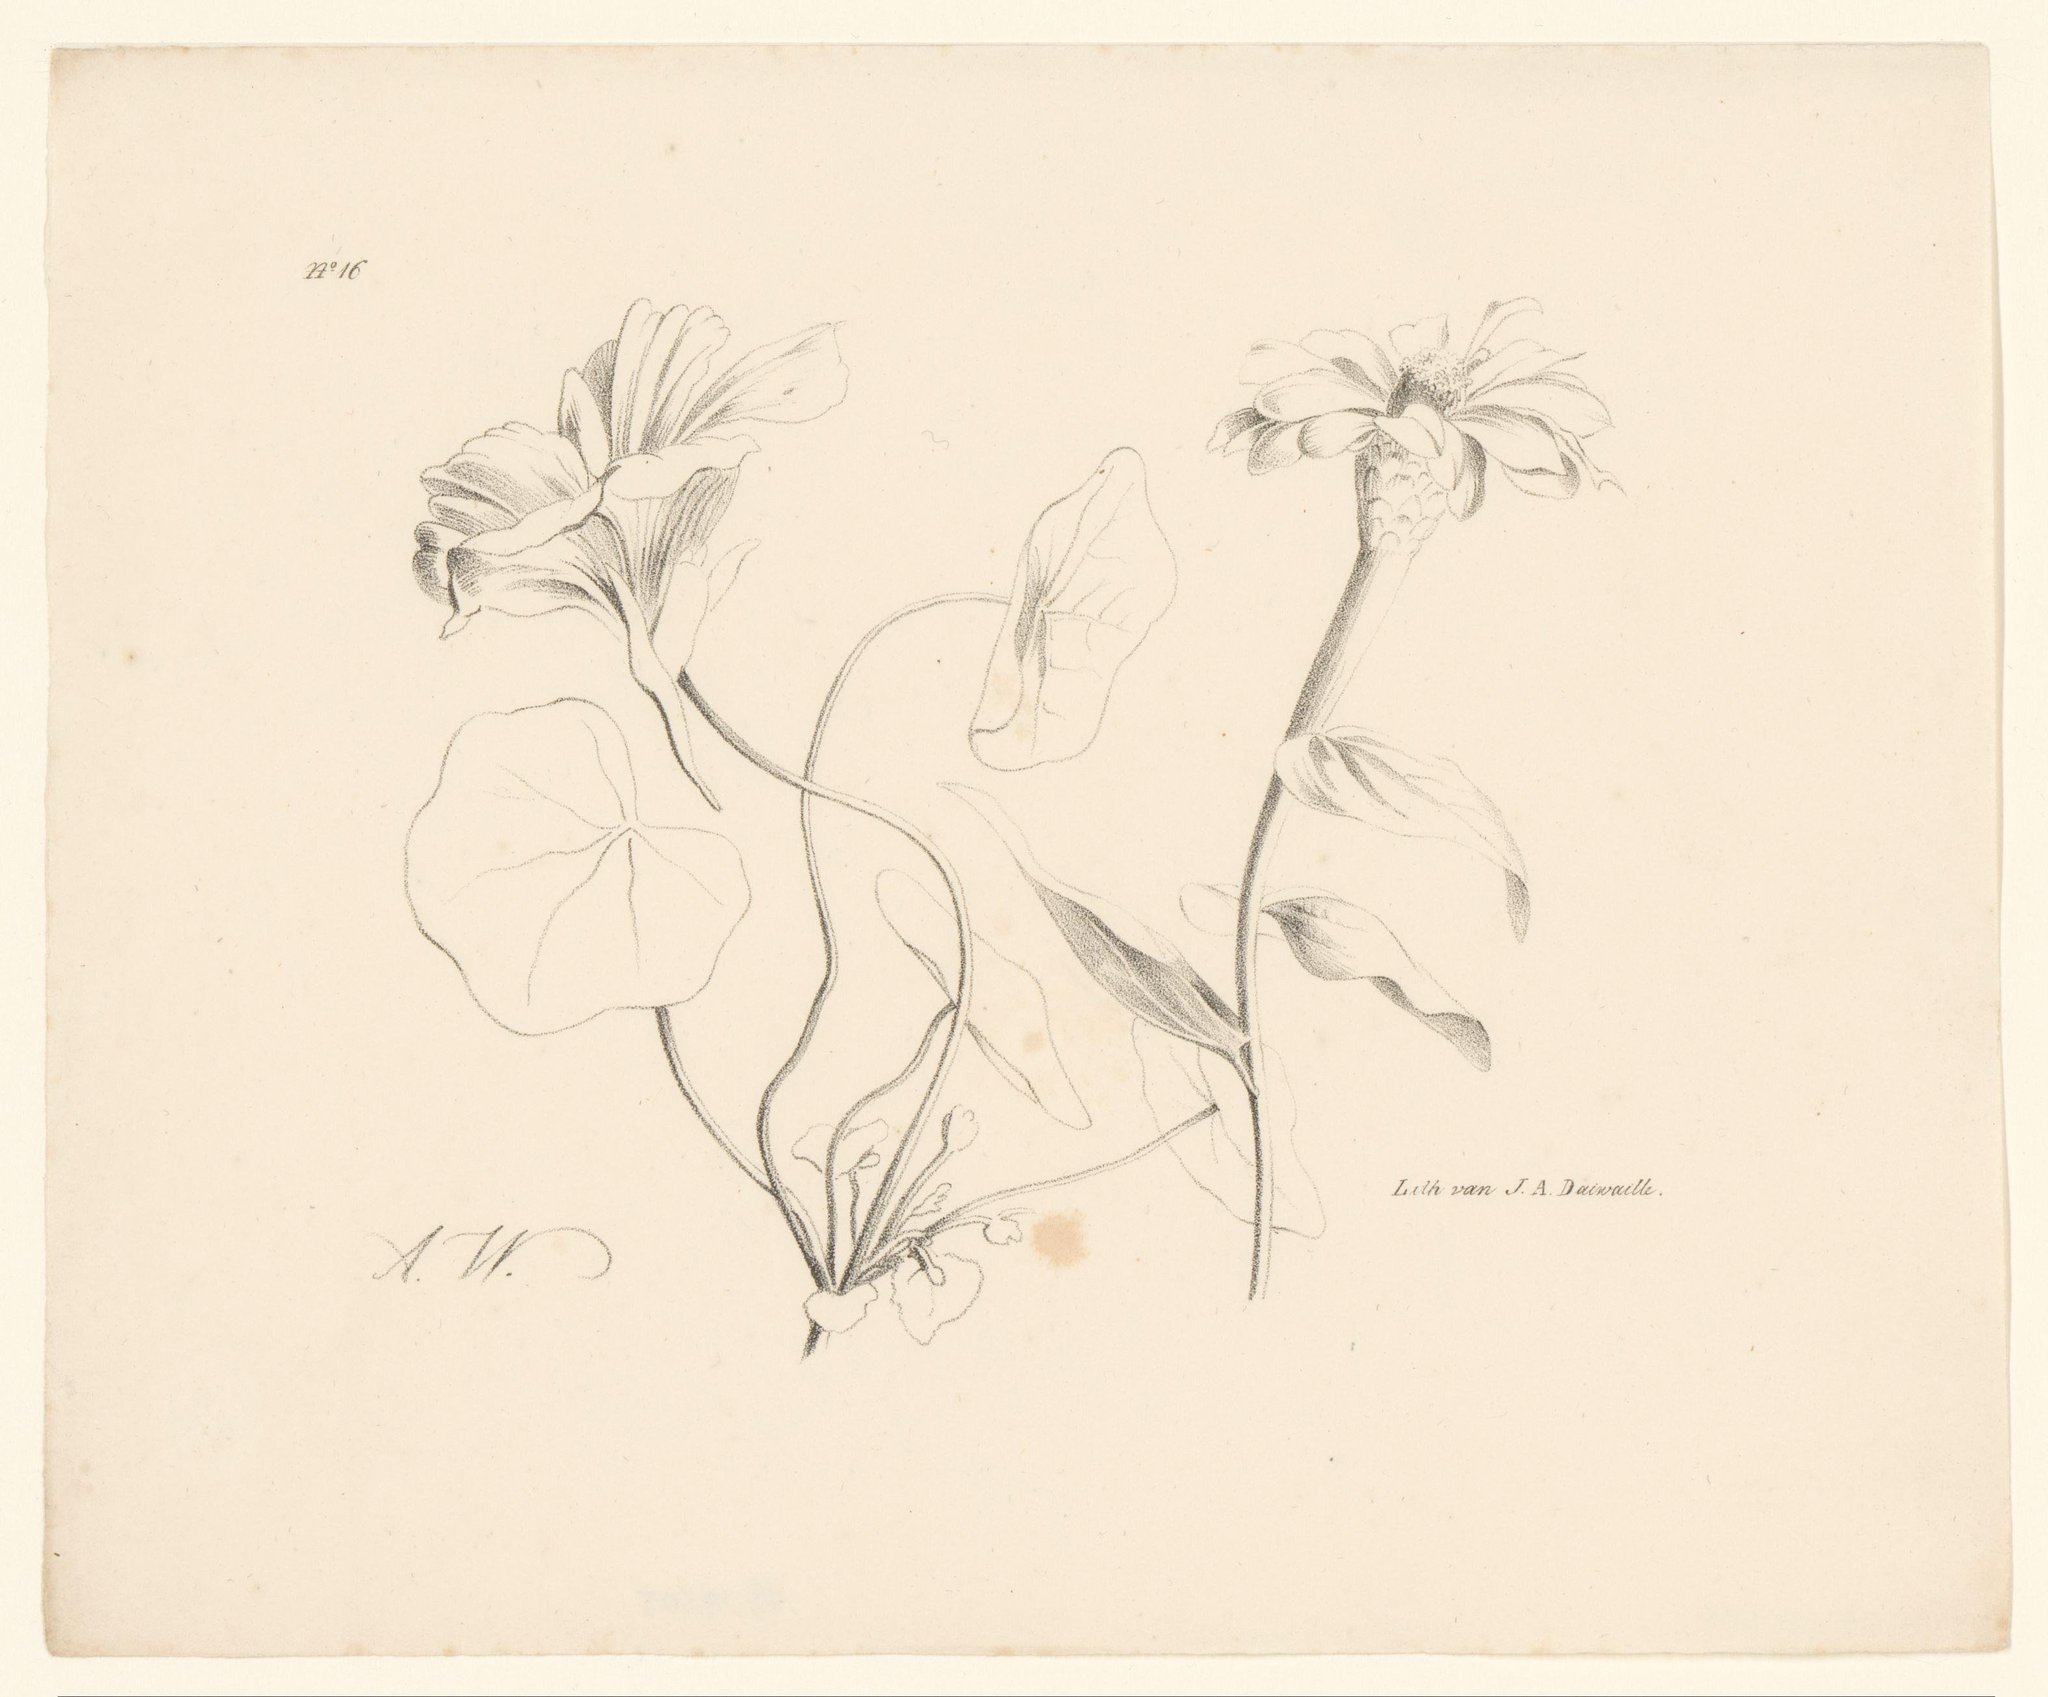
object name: print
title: Bloemen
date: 1820-1833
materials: paper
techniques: lithograph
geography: amsterdam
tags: flowers